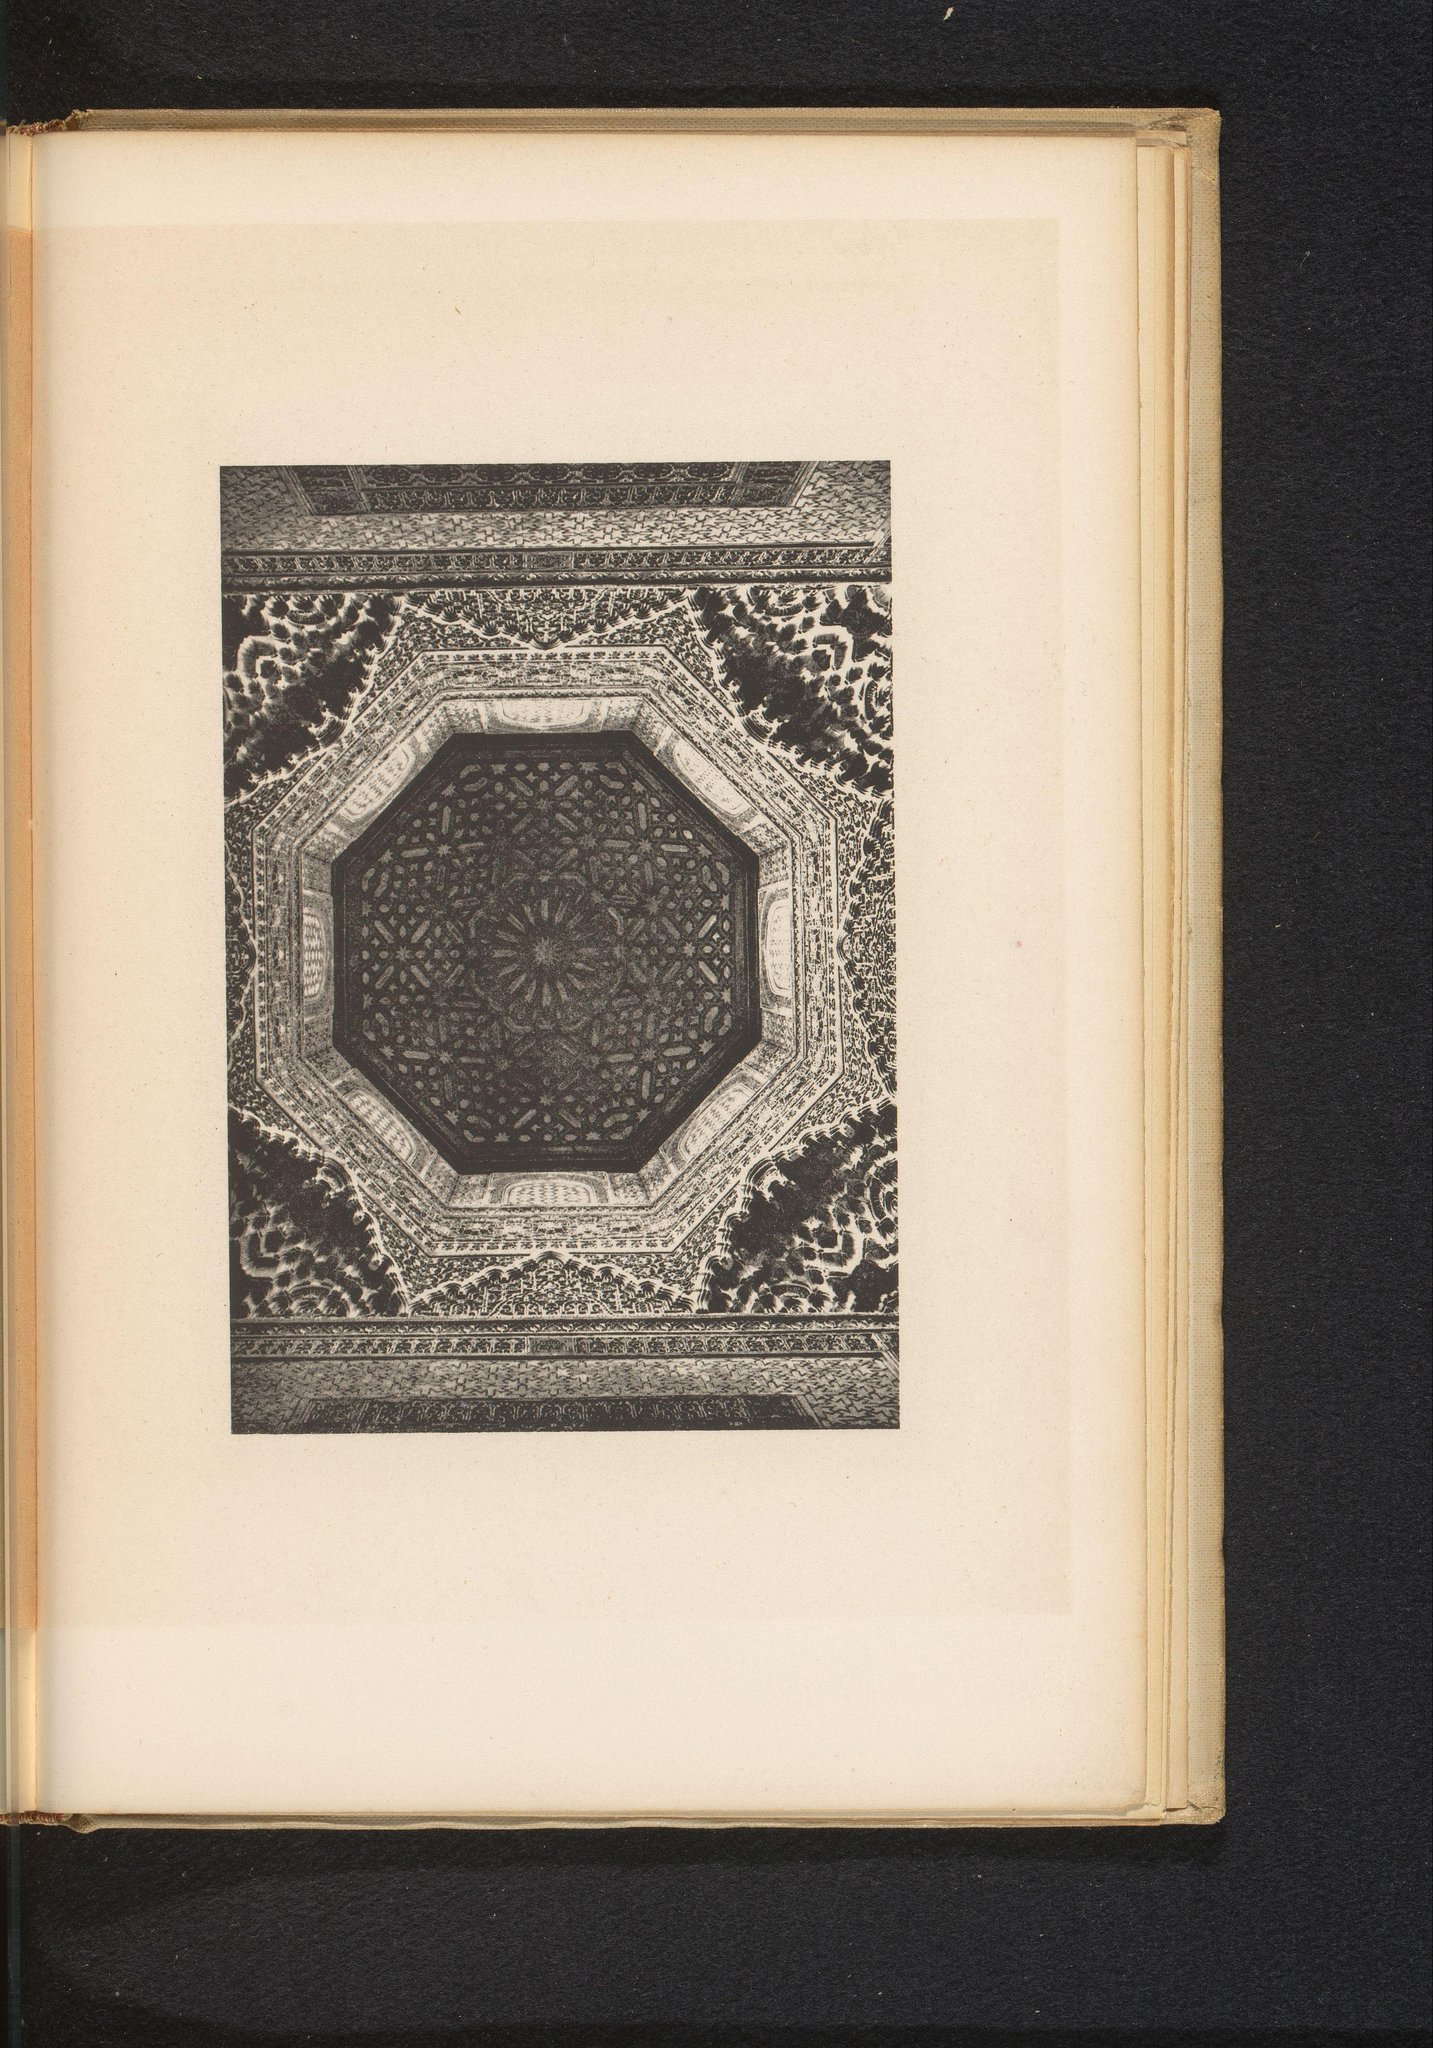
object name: photomechanical print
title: Decorated Ceiling in the Palace of the Alhambra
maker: Anonymous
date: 1884-1894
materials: paper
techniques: photoaquatint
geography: alhambra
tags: (decorated) ceiling